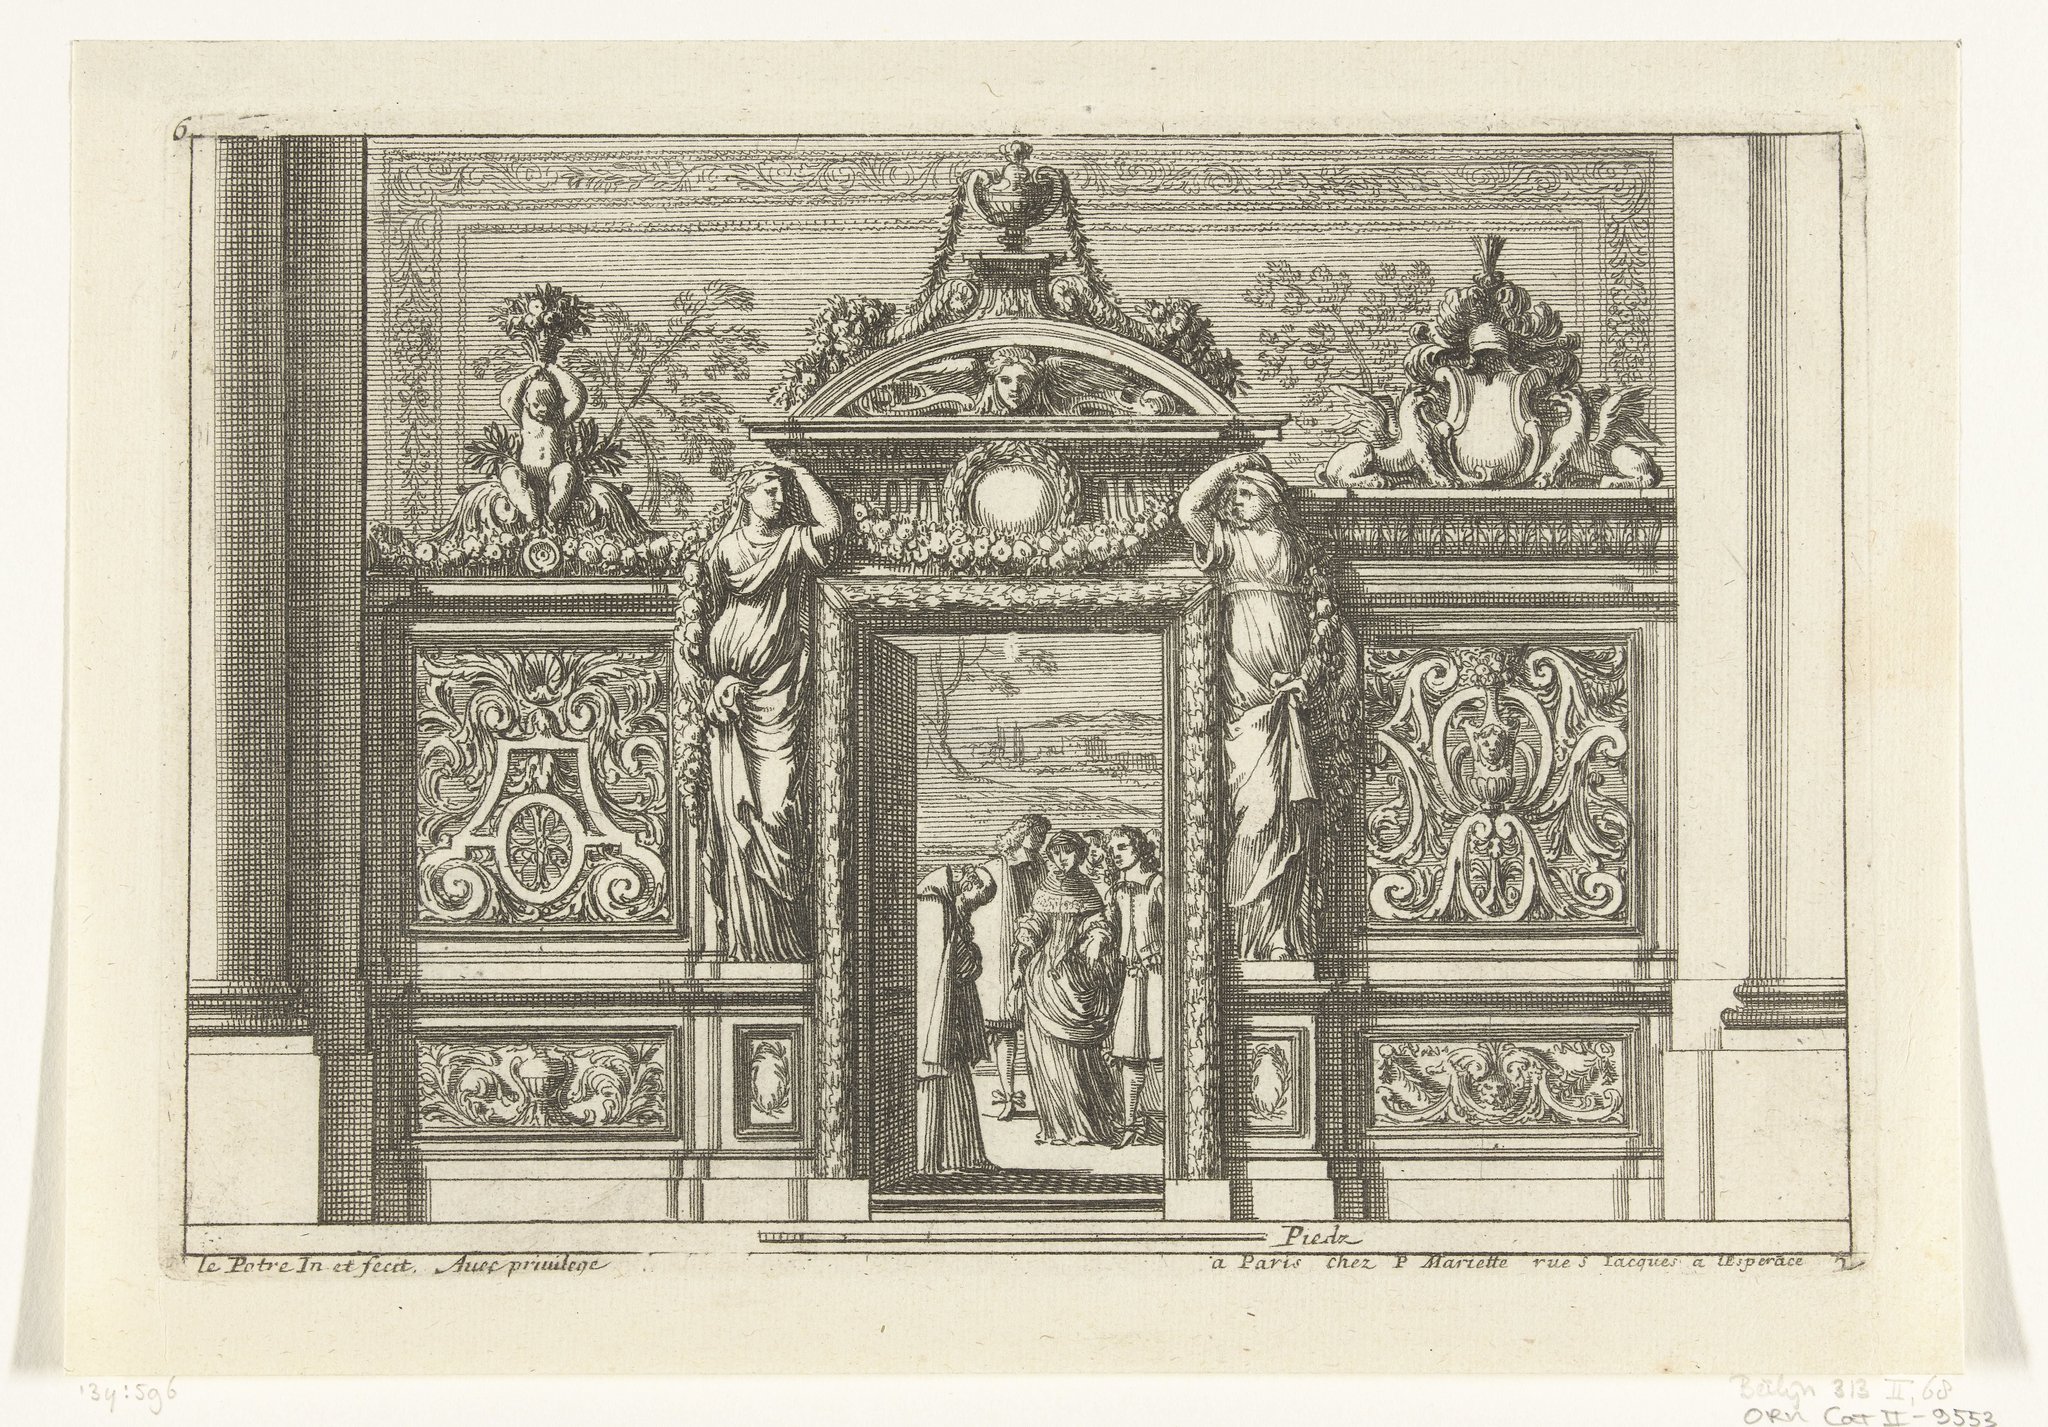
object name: print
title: Koorhek met open deur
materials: paper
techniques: etching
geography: france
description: Door de deur is een monnik zichtbaar. Uit derde editie.